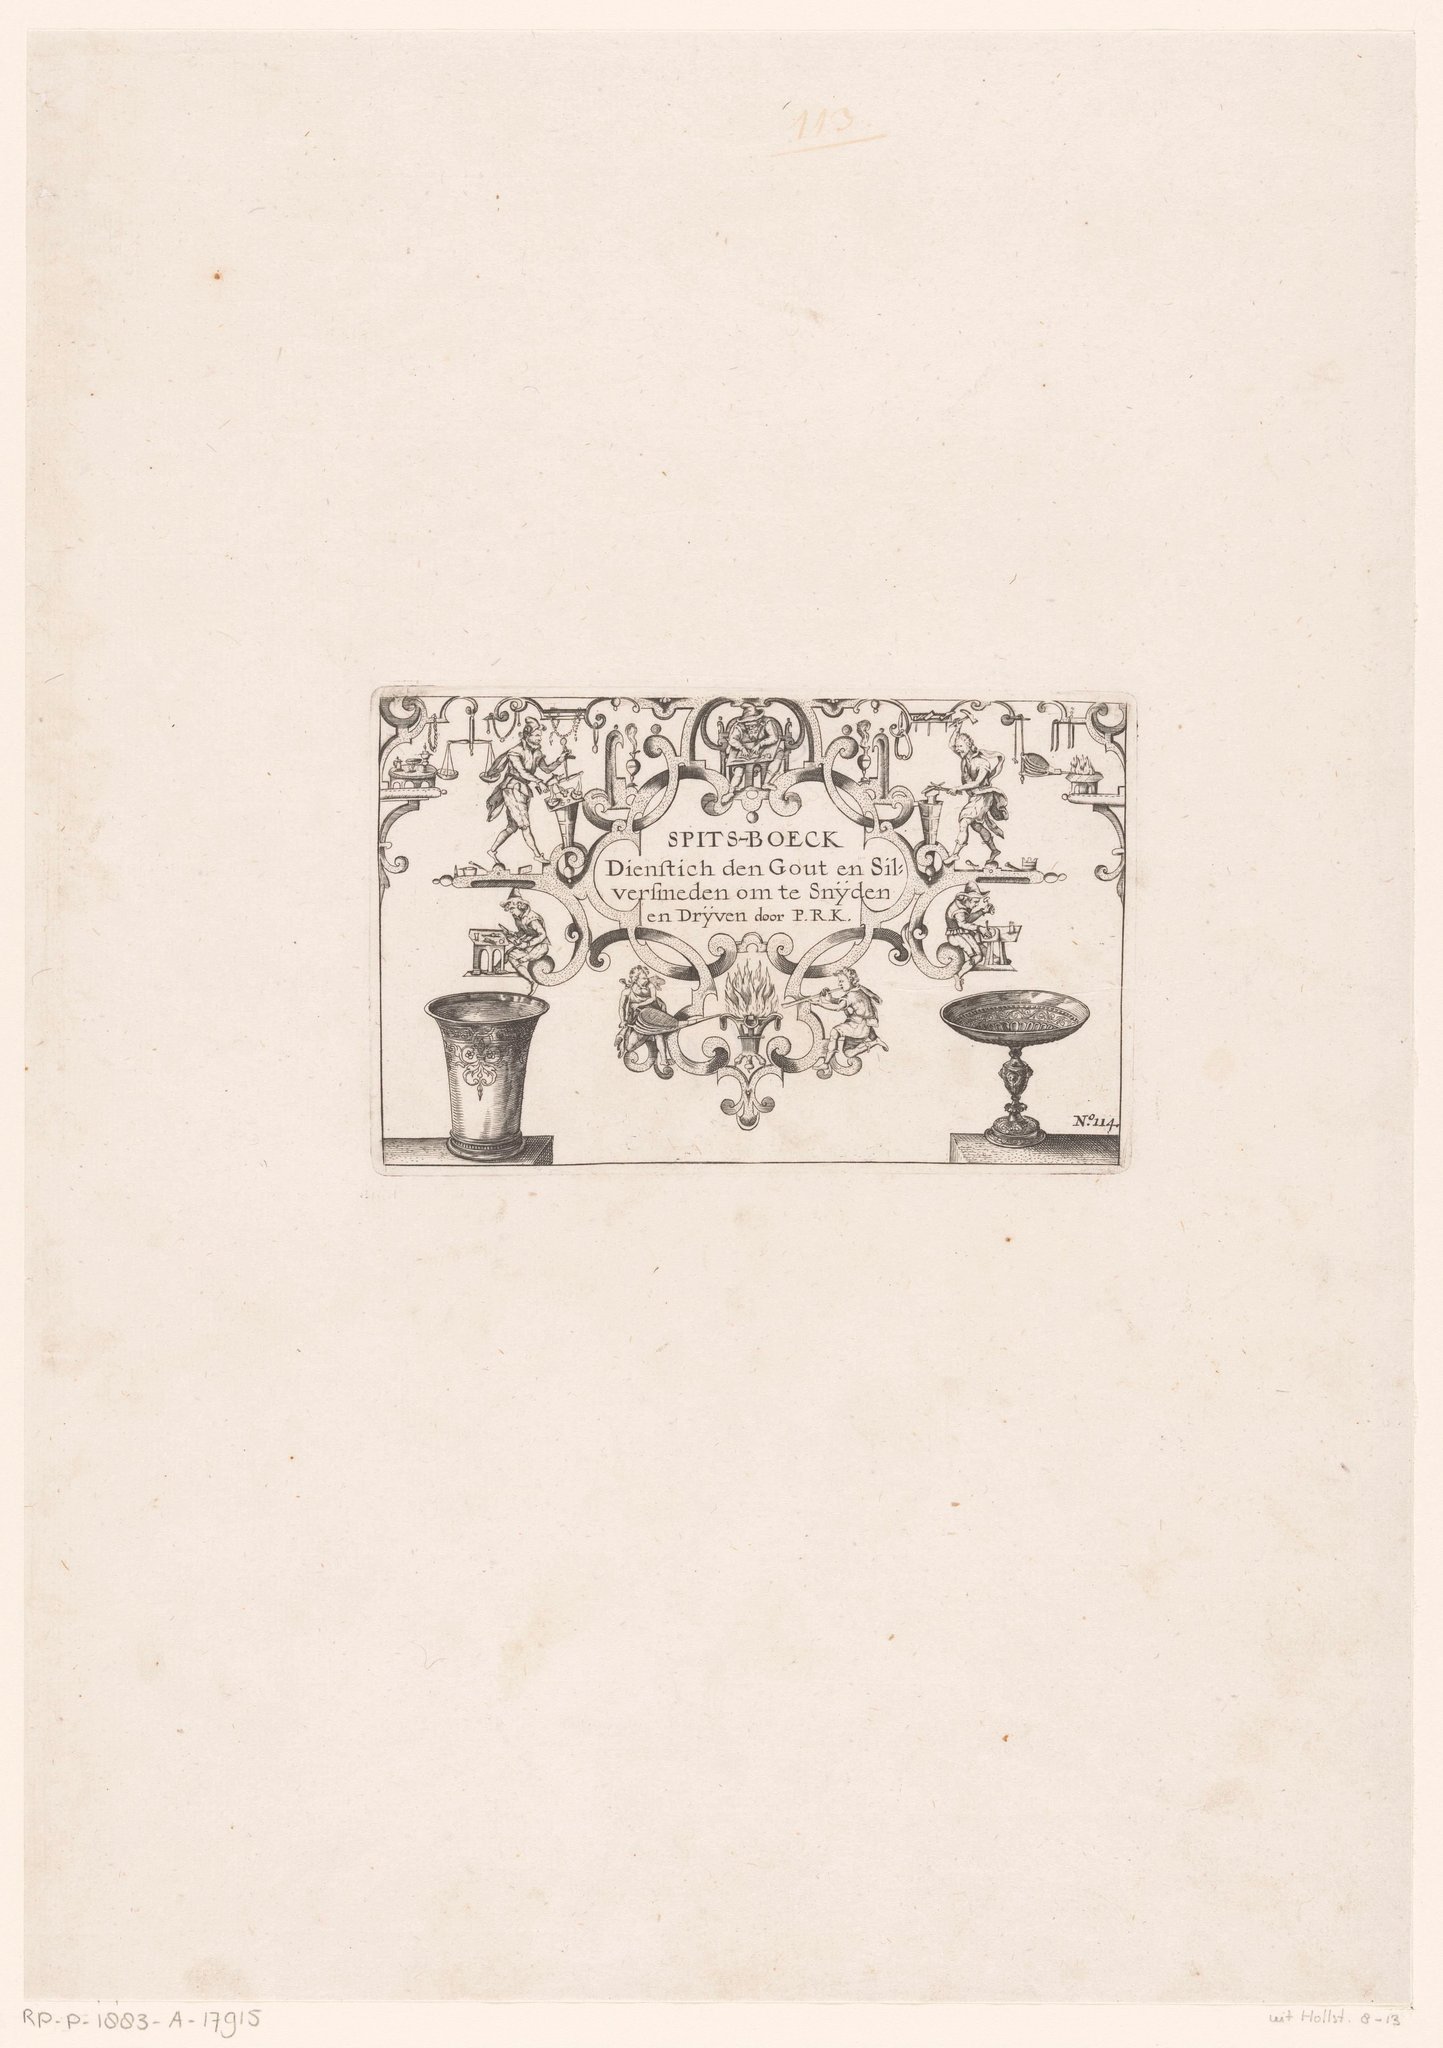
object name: print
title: Spits-Boeck Dienstich den Gout en Silversmeden om te Snijden en Drijven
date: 1720-1730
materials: paper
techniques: etching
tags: ornaments ~ art, jeweller, goldsmith, silversmith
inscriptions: collector's mark: Lugt 2228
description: Cartouche van vlechtwerk met zeven scènes van een goud- of zilversmid aan het werk. In de cartouche de serietitel. Links onder een beker, rechts onder een bokaal. Prentnummer 114.